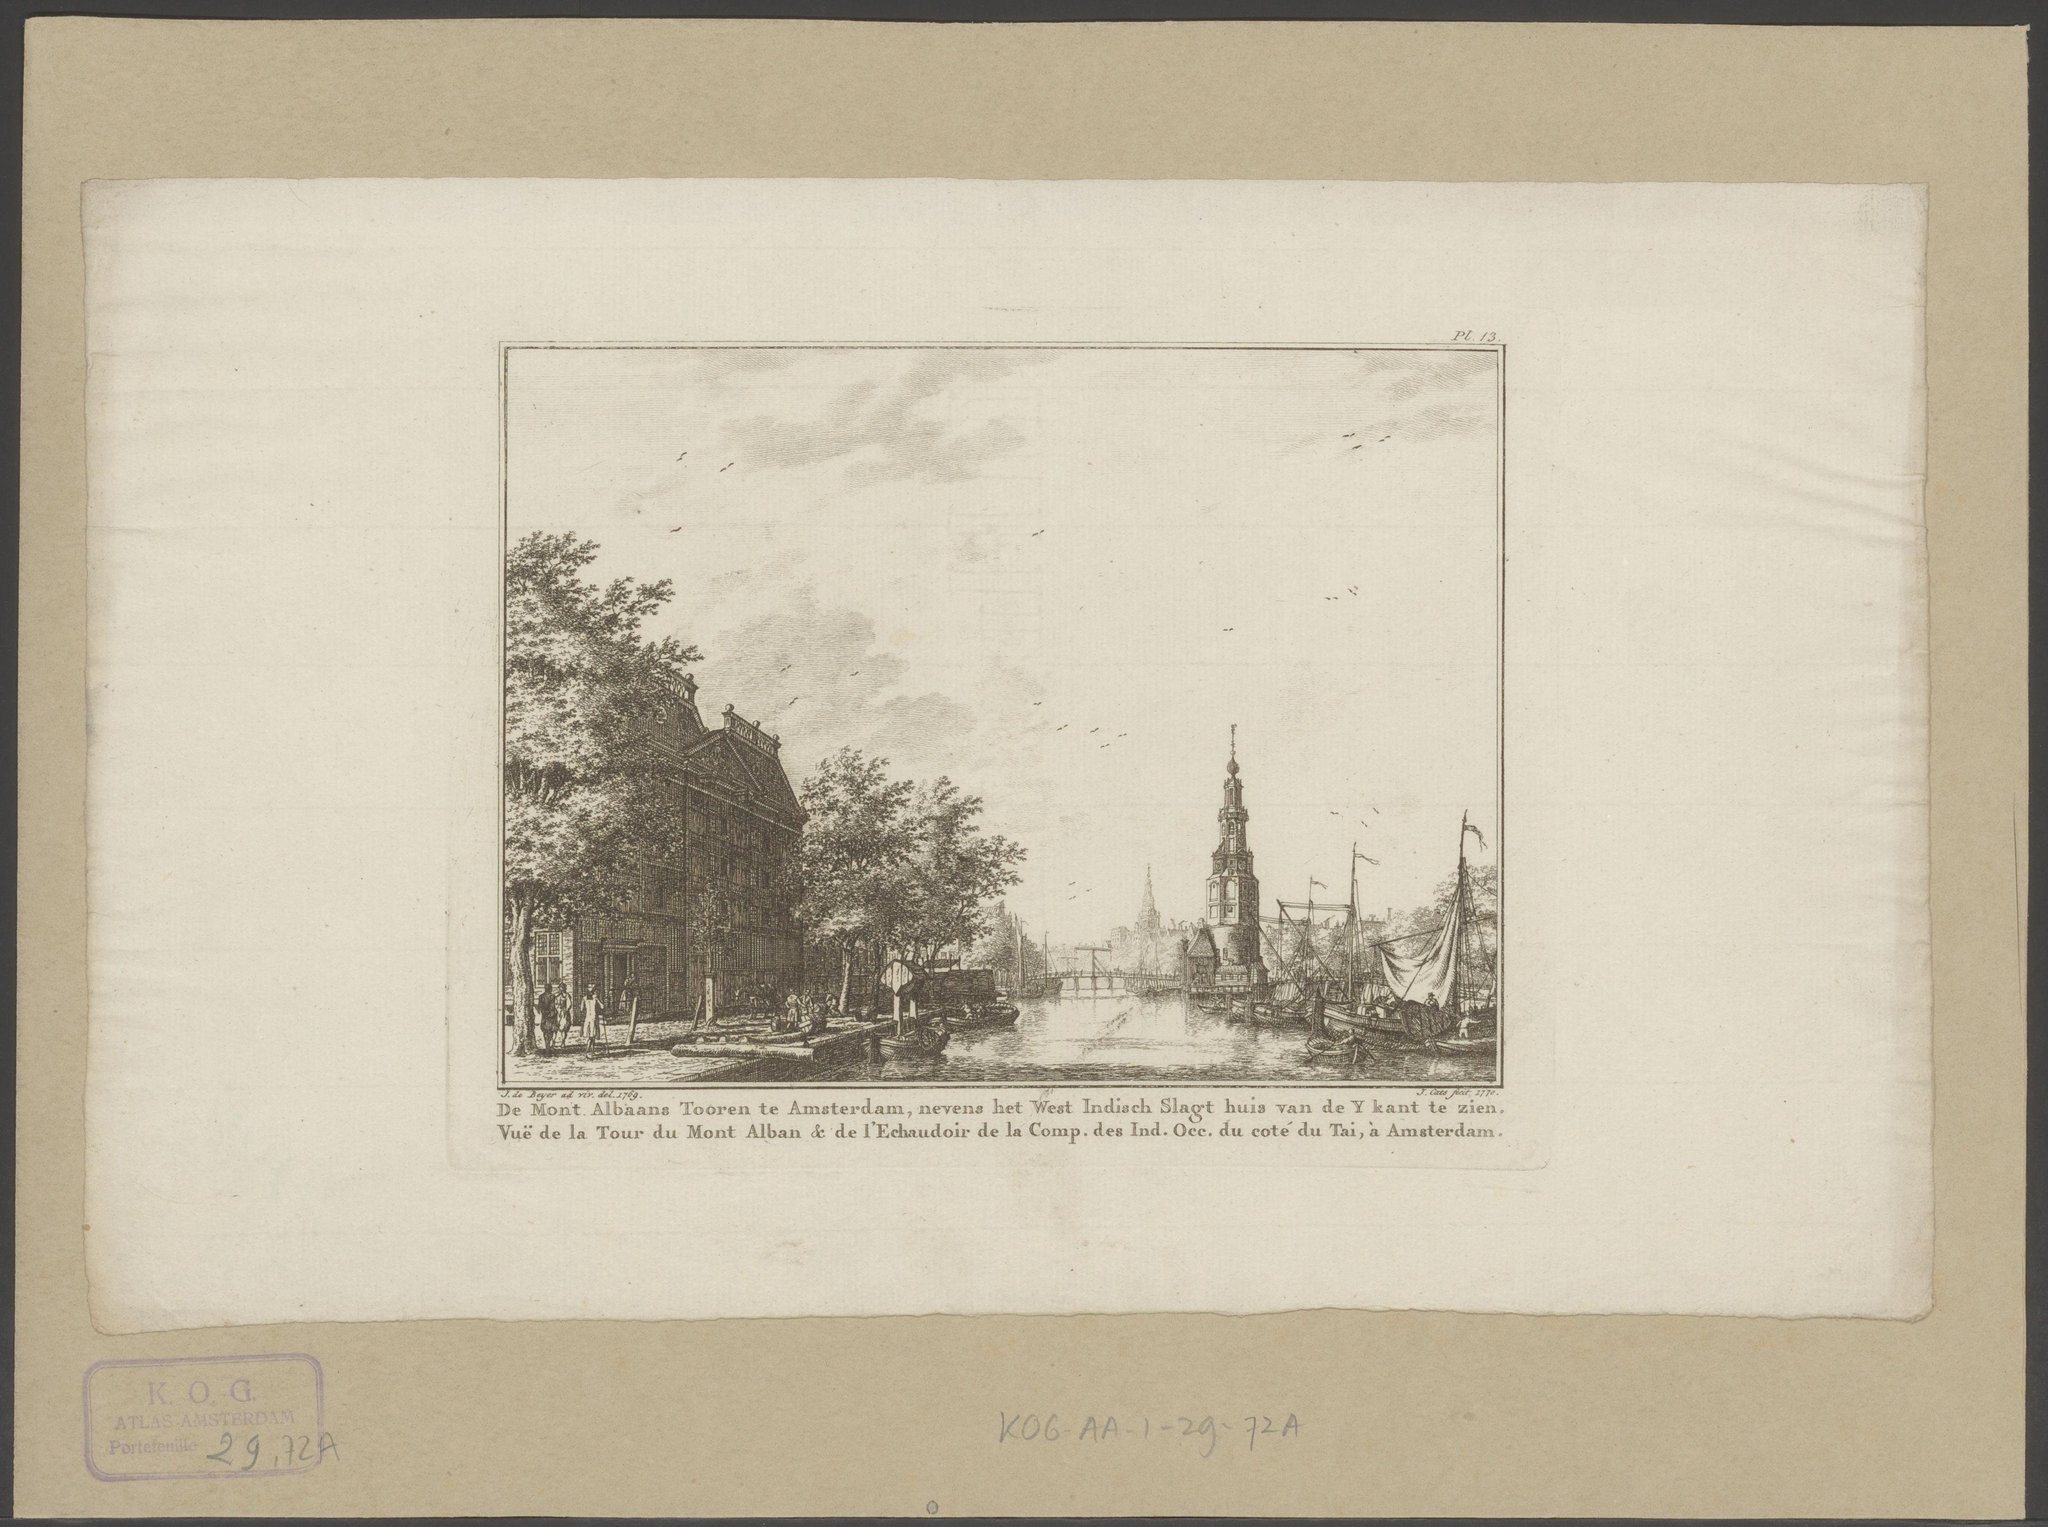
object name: print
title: Gezicht op de Montelbaanstoren te Amsterdam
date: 1824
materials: paper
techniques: engraving, etching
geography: amsterdam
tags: bridge in city across river, canal, etc. (+ city(-scape) with figures, staffage), sailing-ship, sailing-boat, tower, clock tower ~ monumental adornment, rowing-boat, canoe, etc.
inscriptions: collector's mark: Lugt 1641b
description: Prent mogelijk uit: Atlas, of Verzameling van afbeeldingen der voornaamste gebouwen, torens en gezichten der stad Amsterdam (...). Amsterdam: Hendrik Moolenyzer, [1824].